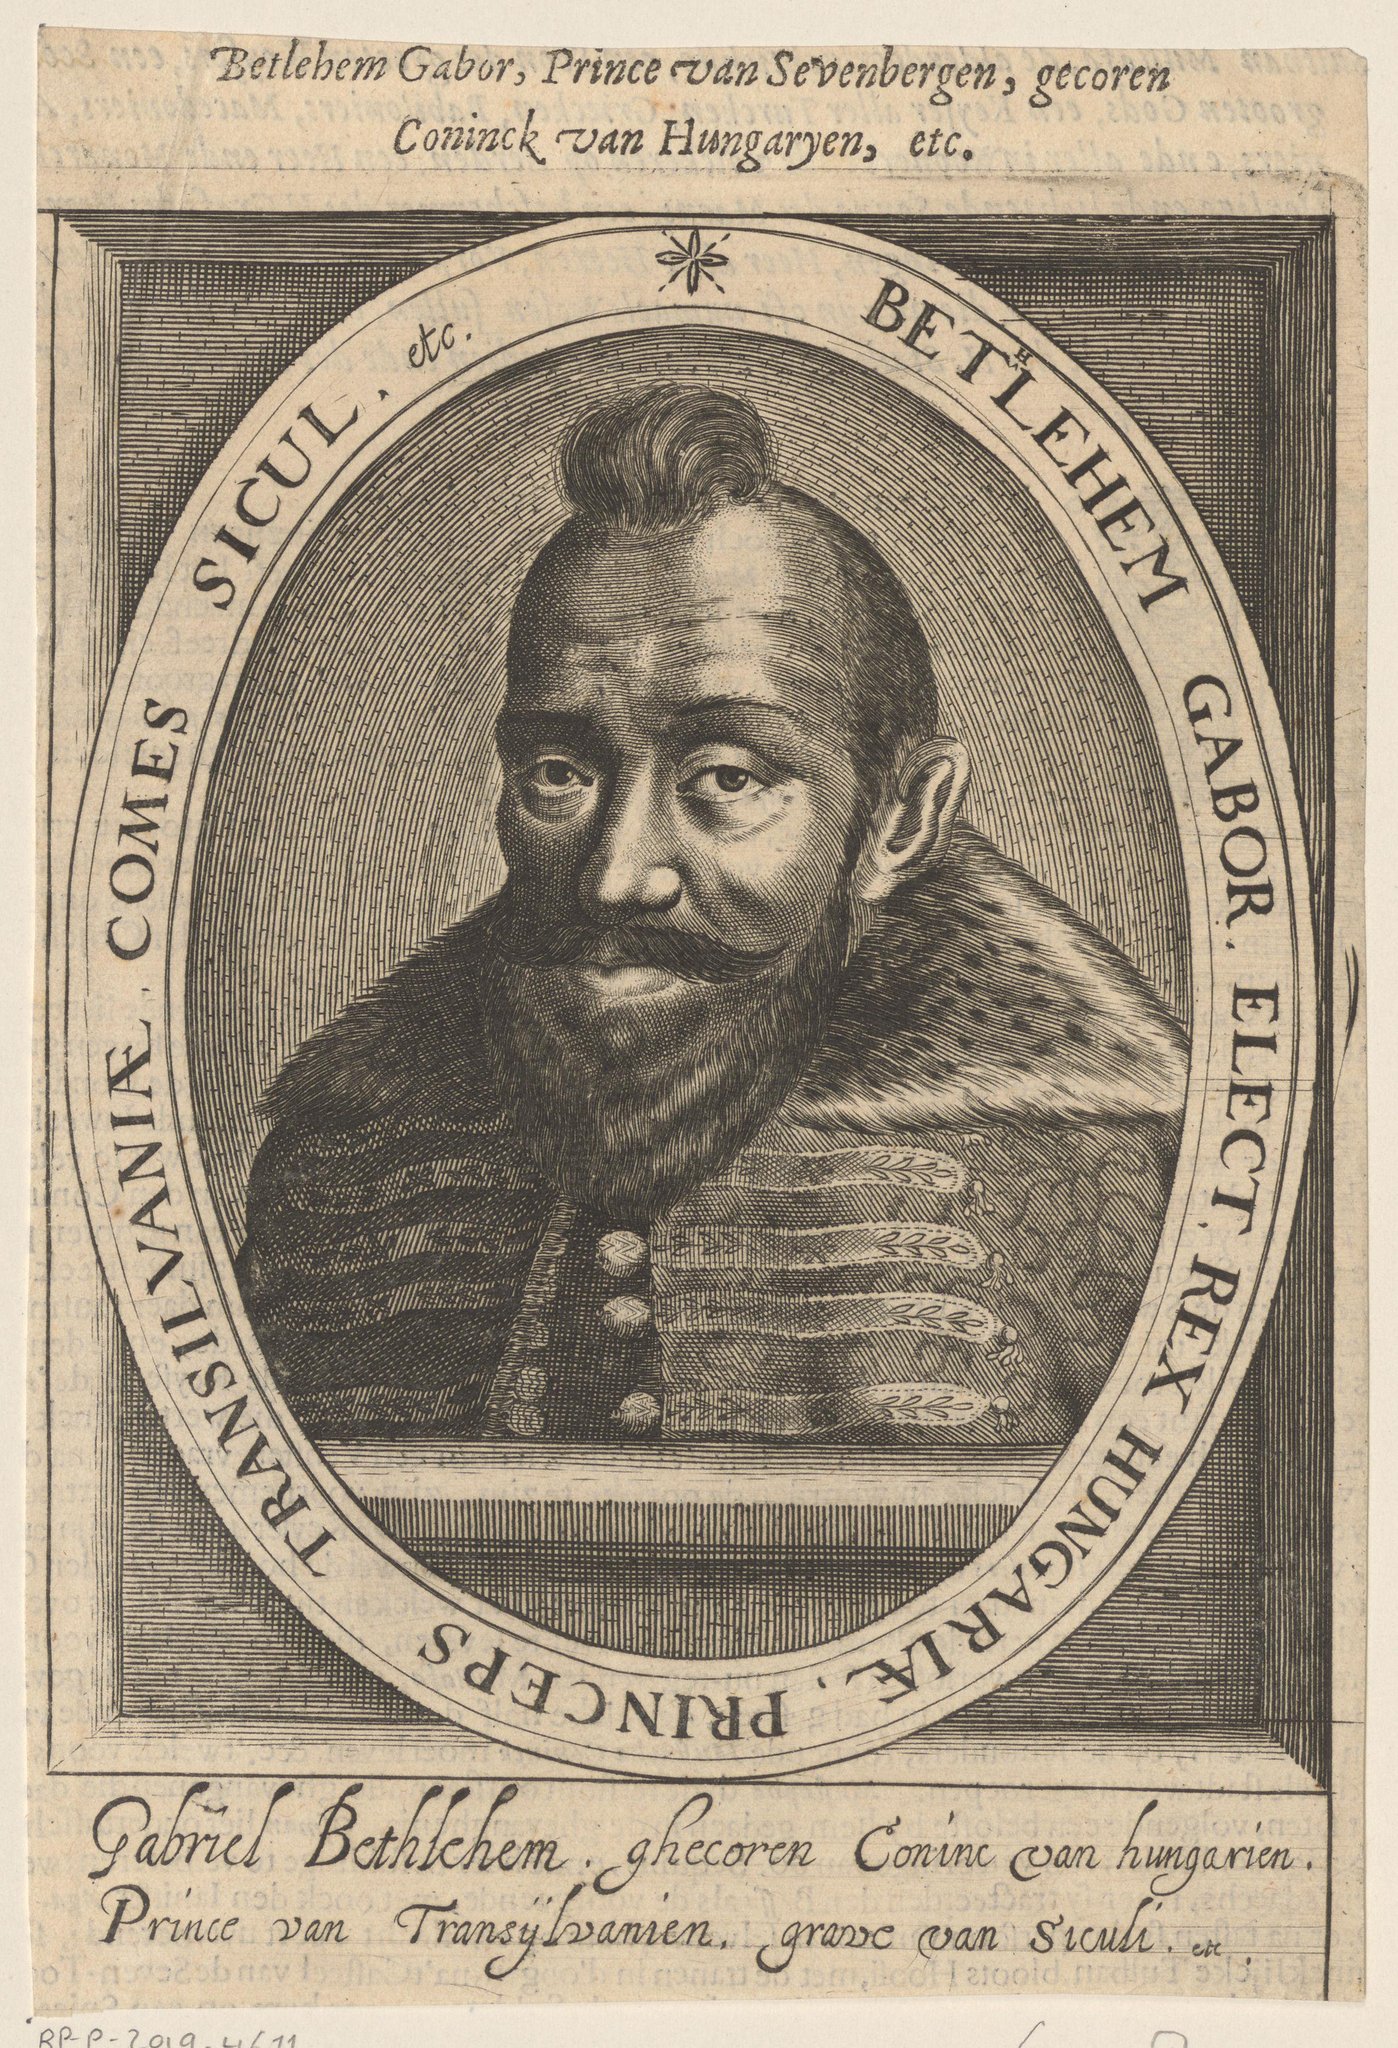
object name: book illustration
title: Portret van Gabriël Bethlen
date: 1625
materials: paper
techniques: engraving, letterpress printing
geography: delft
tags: historical persons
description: Prent uit: Clerck, Nicolaes de. Princelyk cabinet. Verthoonende t'leven afcomste ende afbeeldingen der voornaemste vorste[n], princen, graven en[de] heeren van Europa (...). Delft: erven Nicolaes de Clerck, 1625, p. 107.